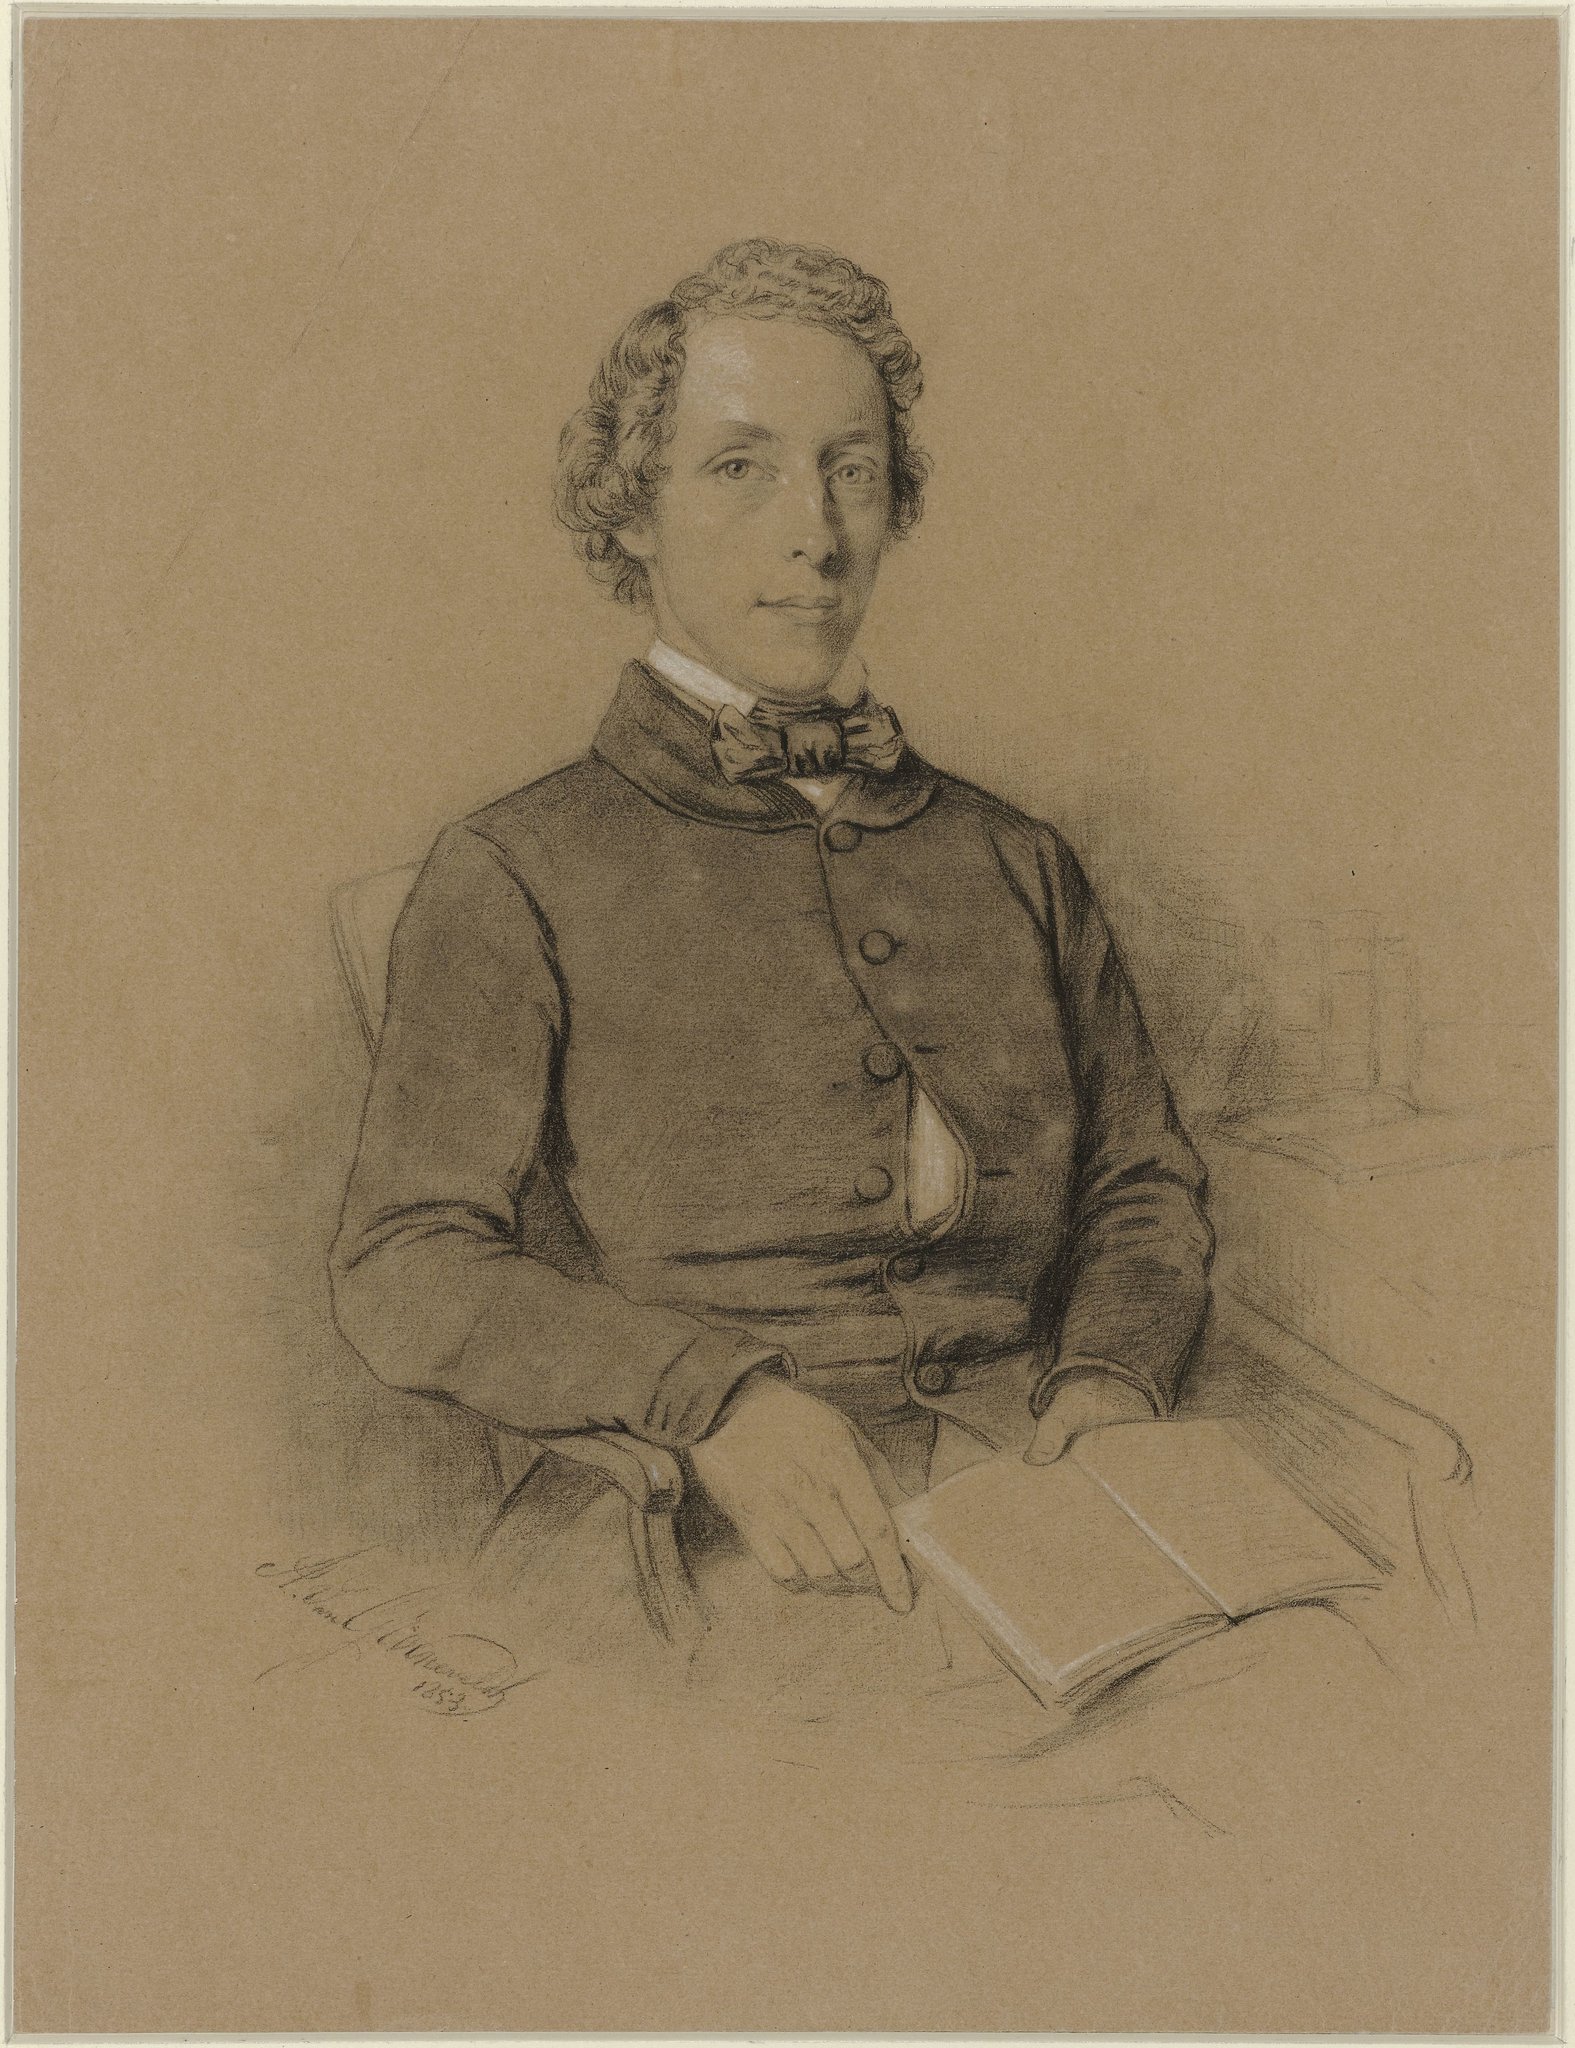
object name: drawing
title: Portret van Petrus Augustus de Génestet, zittend met een boek op schoot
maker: antonie johannes groeneveldt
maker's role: draughtsman, print maker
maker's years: 1824-1883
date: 1853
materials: chalk, paper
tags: petrus augustus de génestet, historical persons, portrait of a writer, portrait, self-portrait of artist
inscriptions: date: ‘1853’